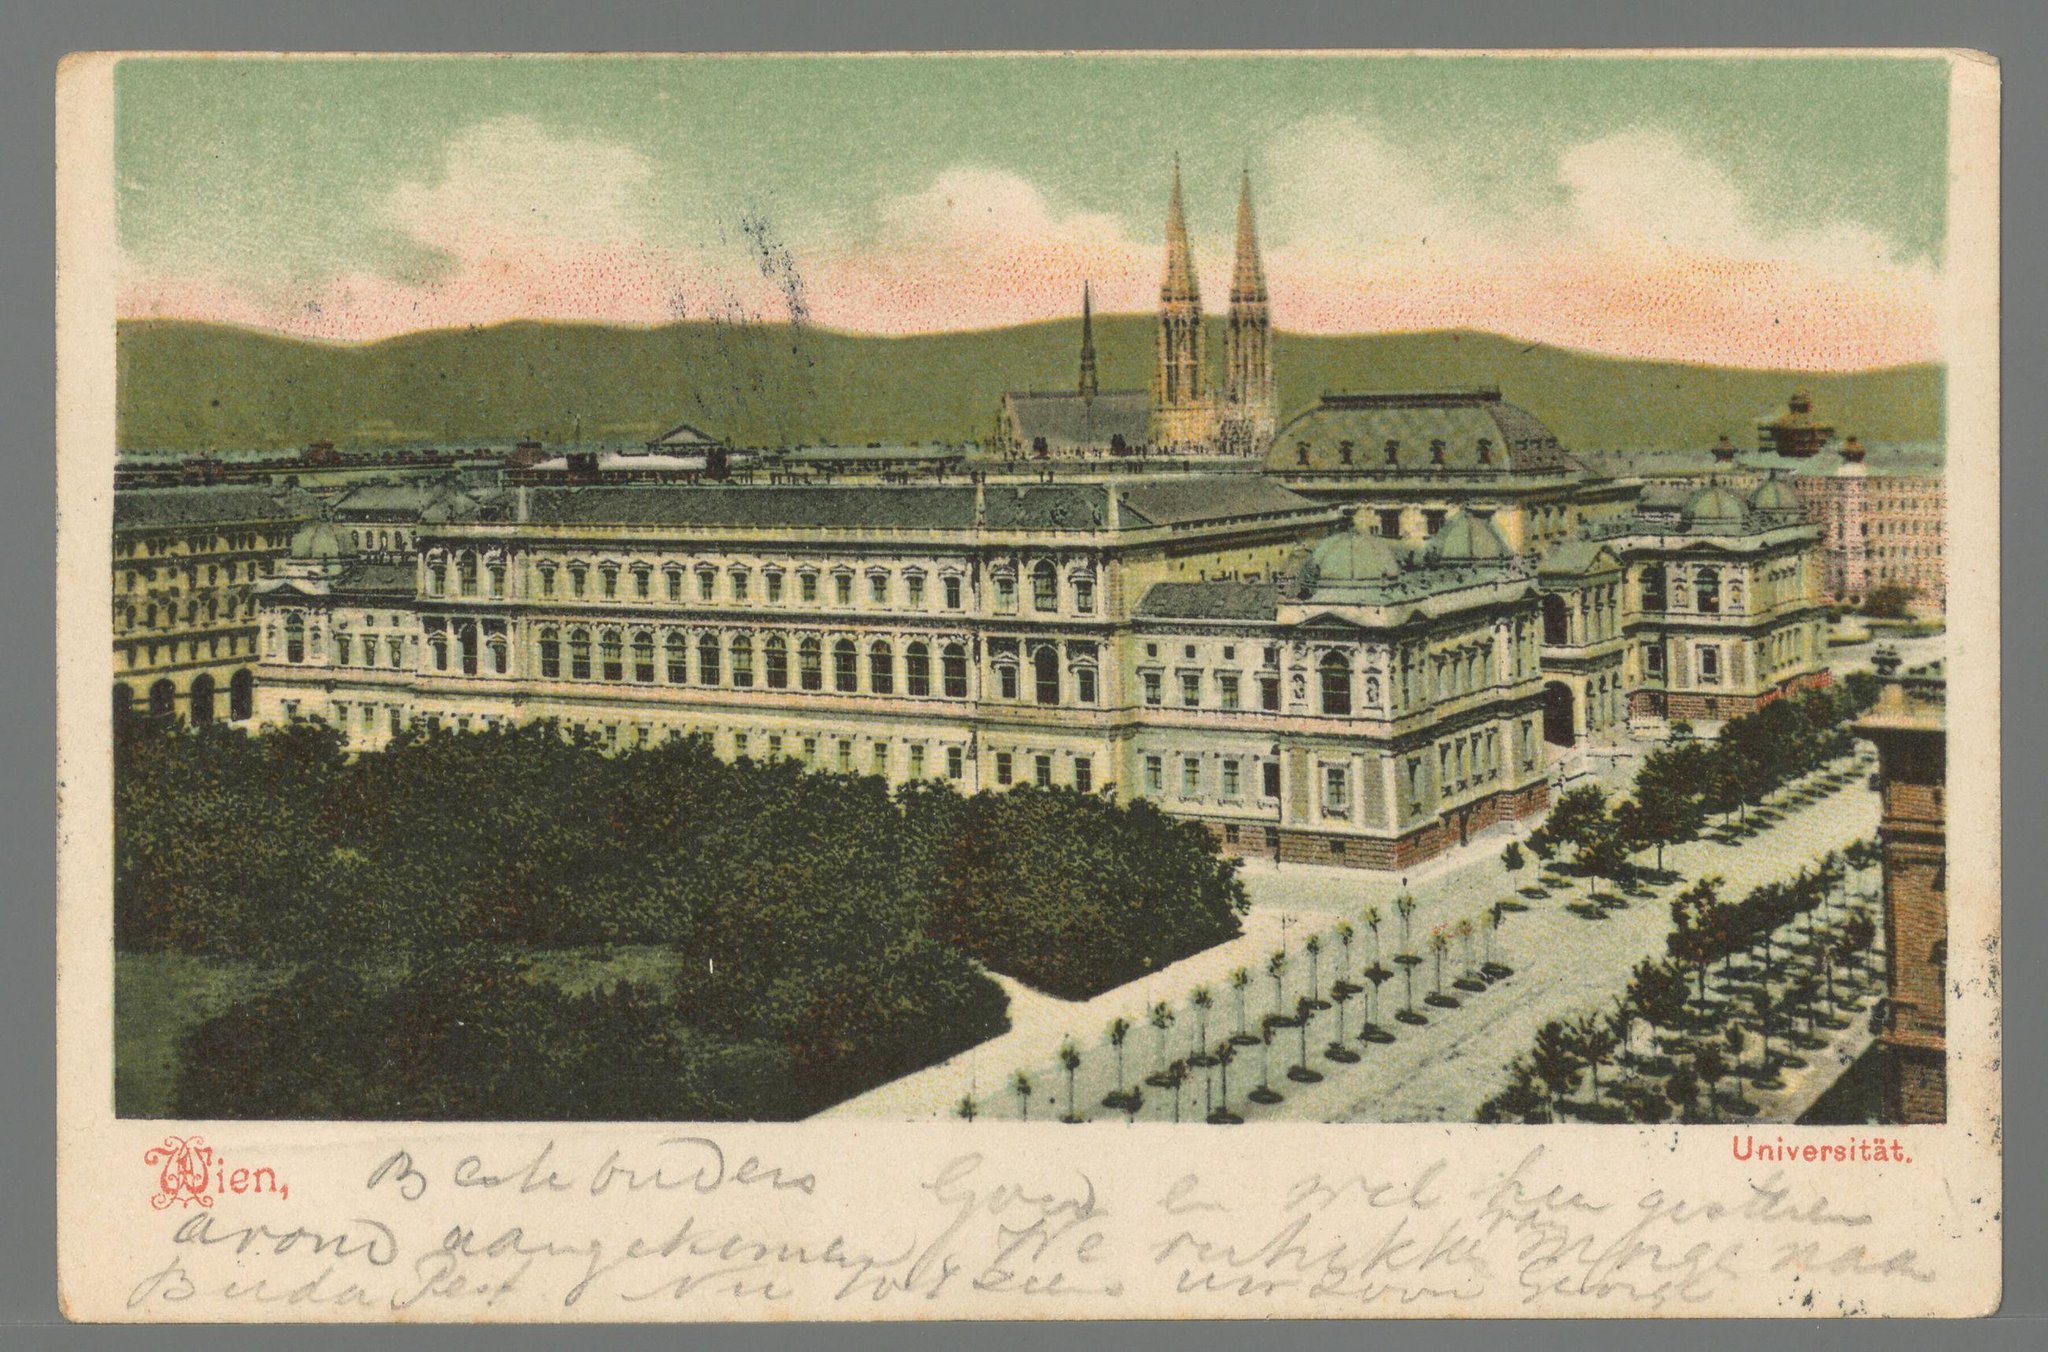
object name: photomechanical print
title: Wien, Universität.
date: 1870-1904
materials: cardboard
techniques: photograph, lithograph, writing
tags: university building, college, vienna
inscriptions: postage stamp